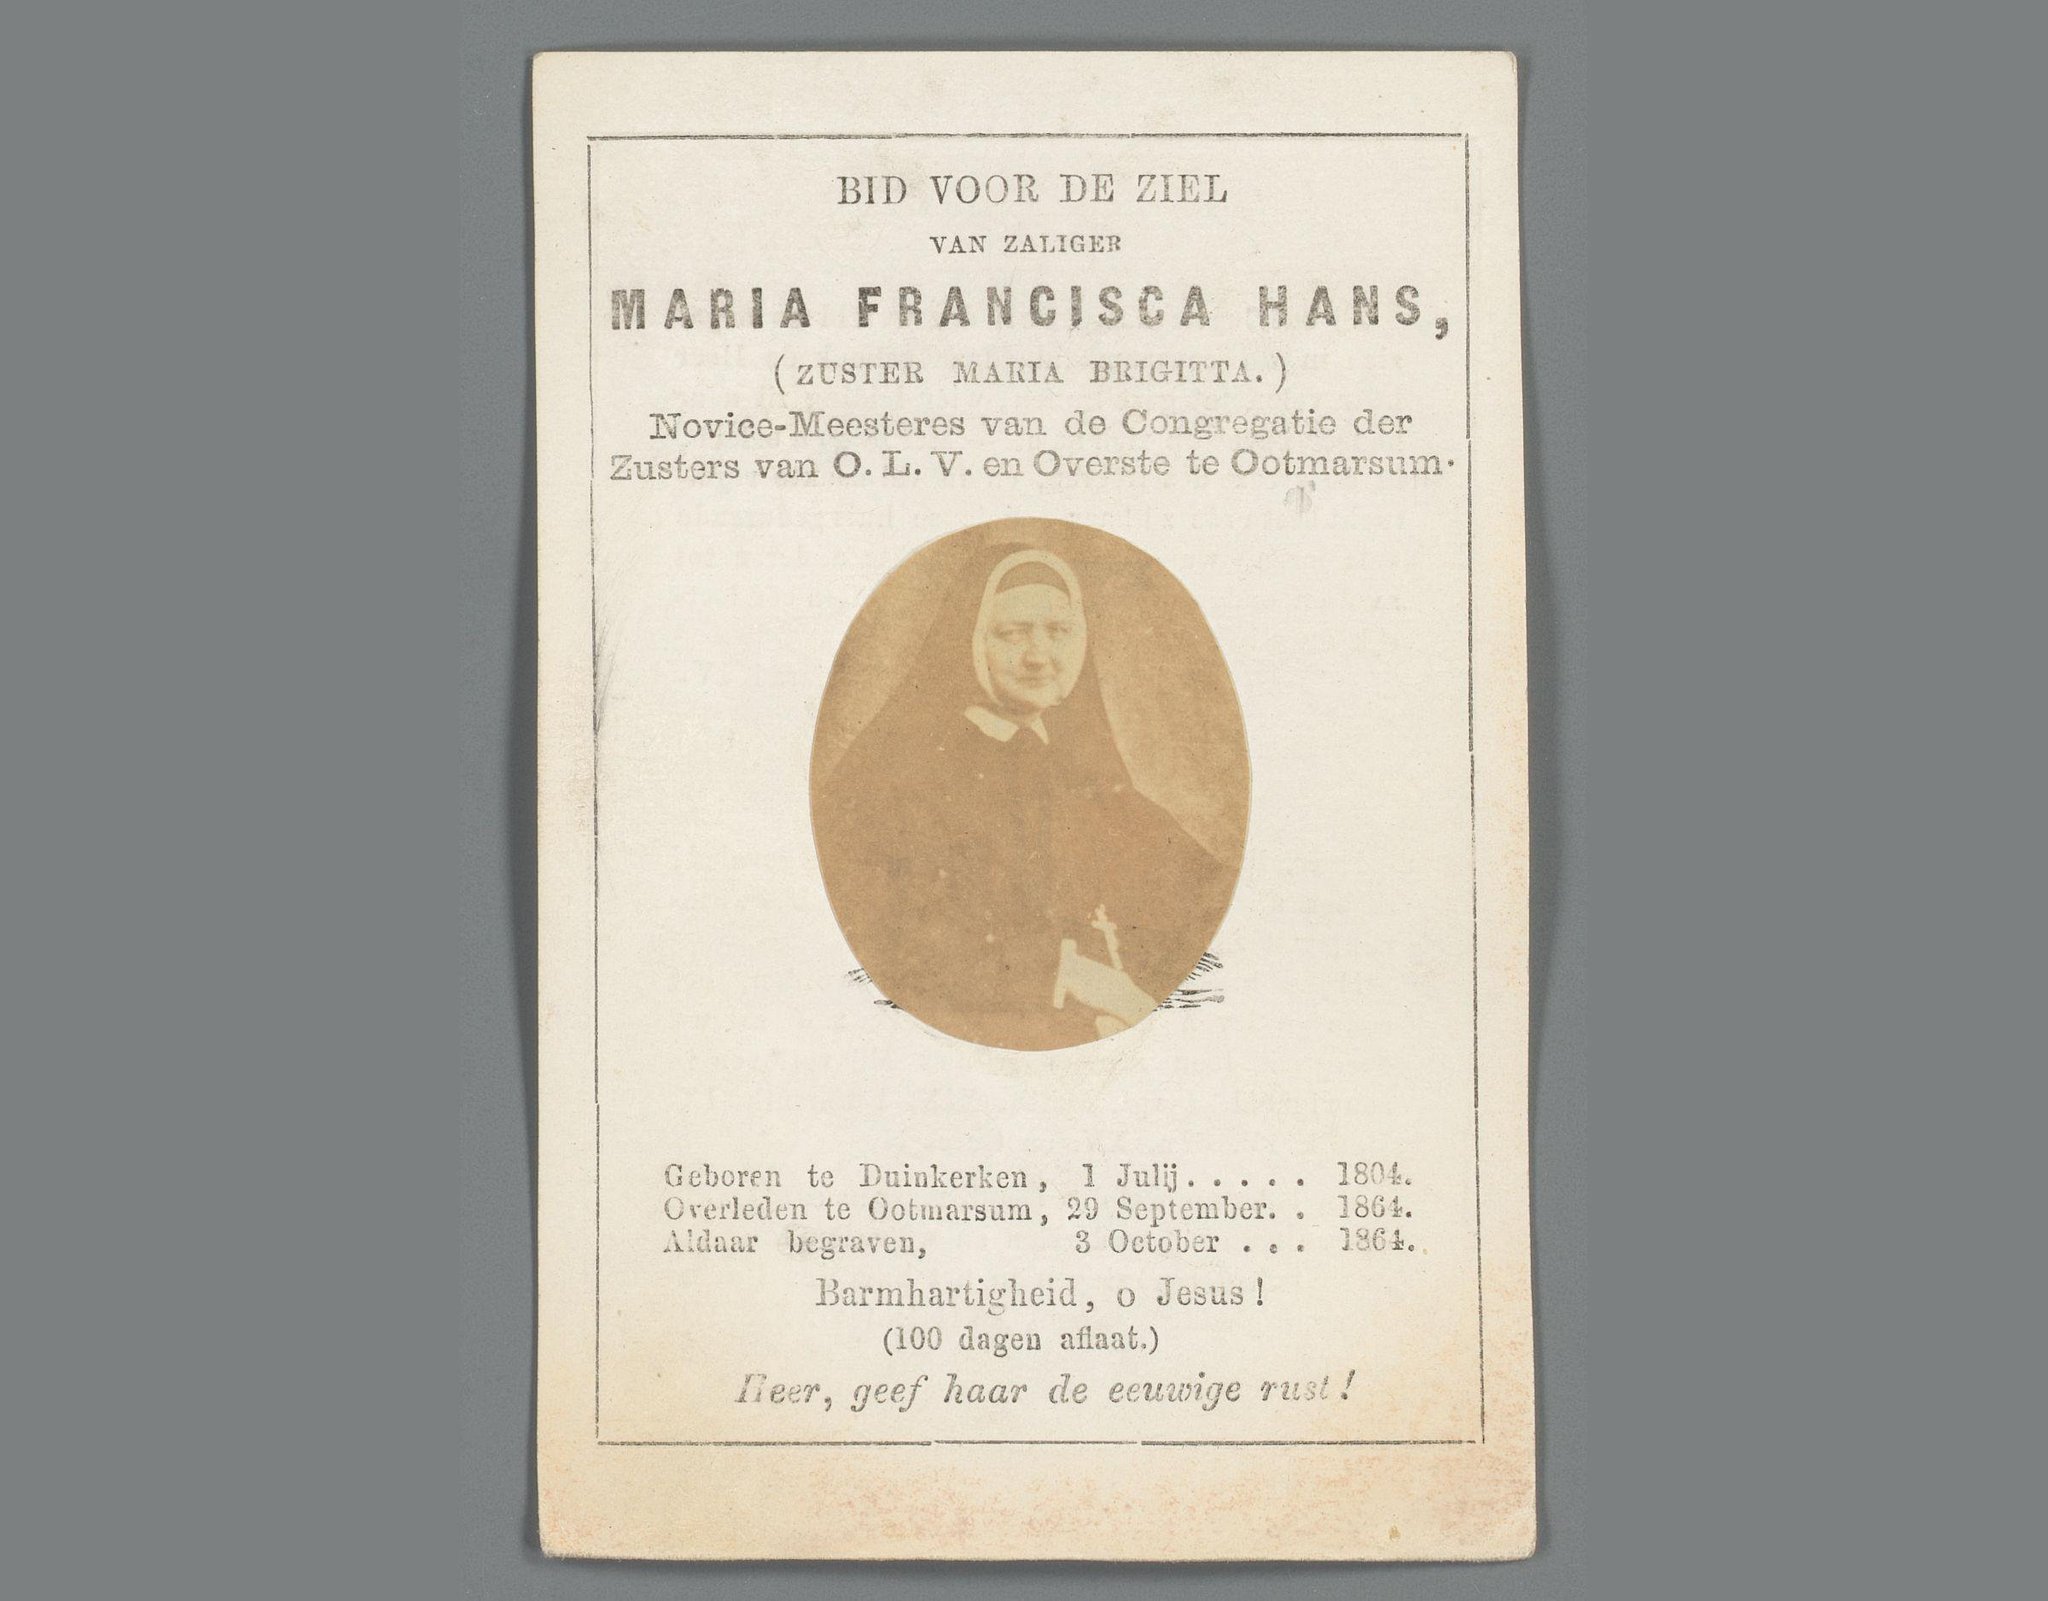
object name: prayer card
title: Portret van Maria Francisca Hans op bidprent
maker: Anonymous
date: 1864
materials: paper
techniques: albumen print, letterpress printing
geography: ootmarsum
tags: nun(s), historical persons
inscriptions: inscription: ‘Bid voor de ziel/ van zaliger/ Maria Francisca Hans,/ (Zuster Maria Brigitta.) (...) Heer, geef haar de eeuwige rust!’, inscription: ‘Zij ontvlugtte (...)Joan. XVI. Isaias XXXVIII.’